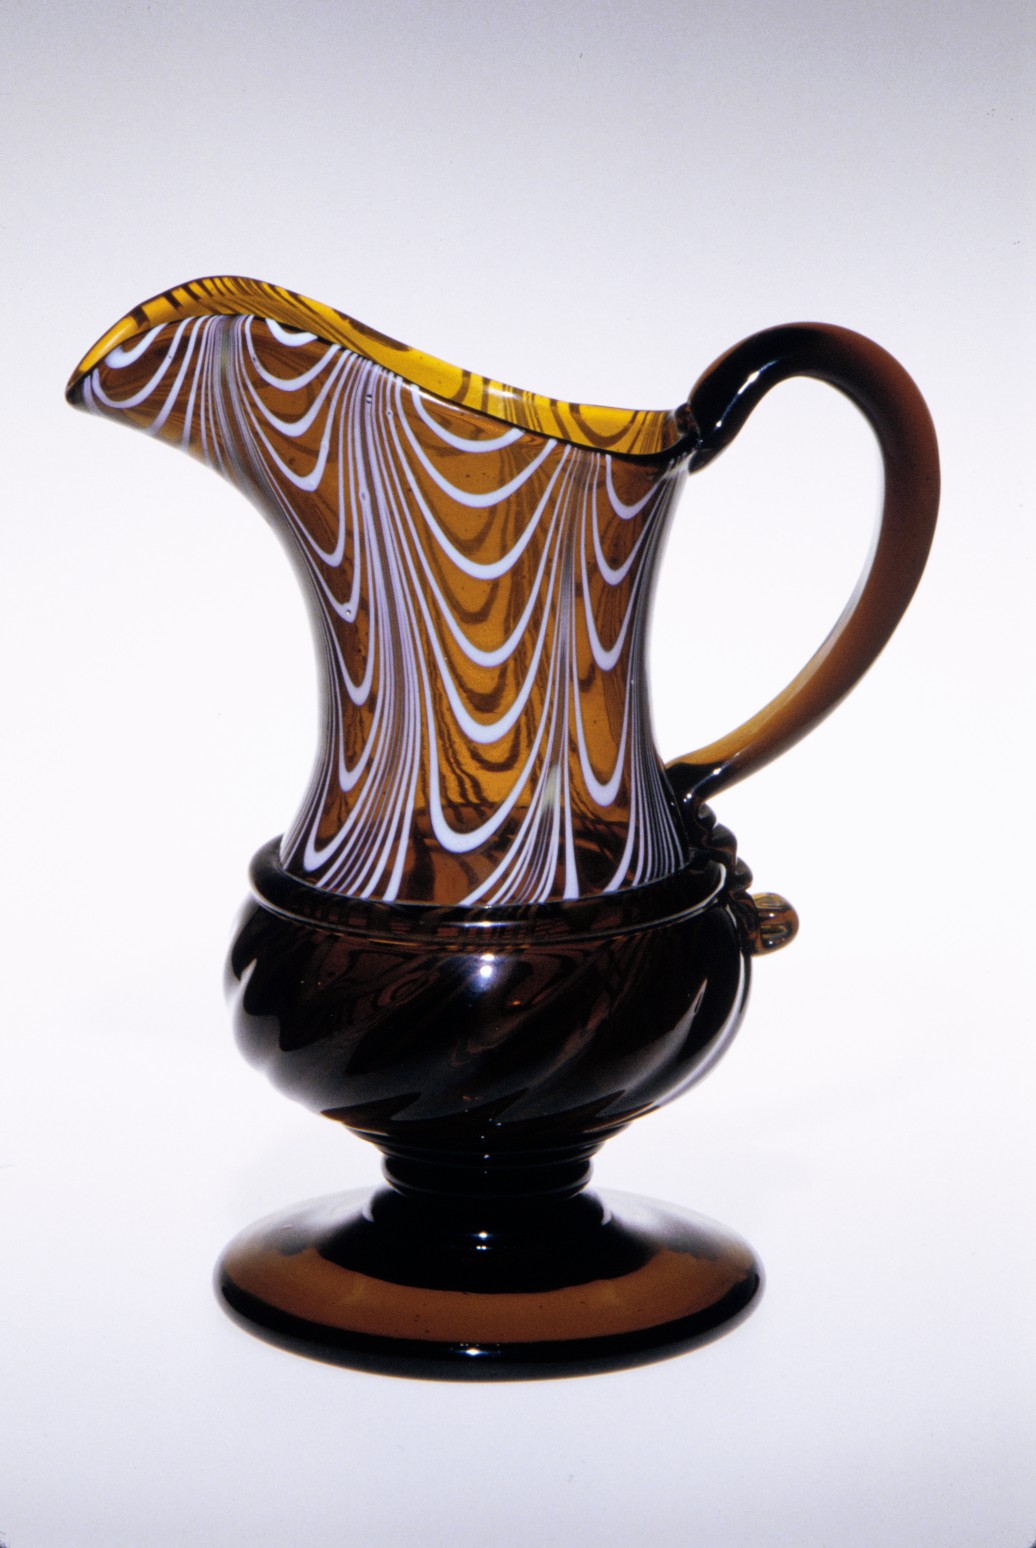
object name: pitcher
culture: american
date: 1830-1870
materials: amber, glass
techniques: glassblowing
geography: united states